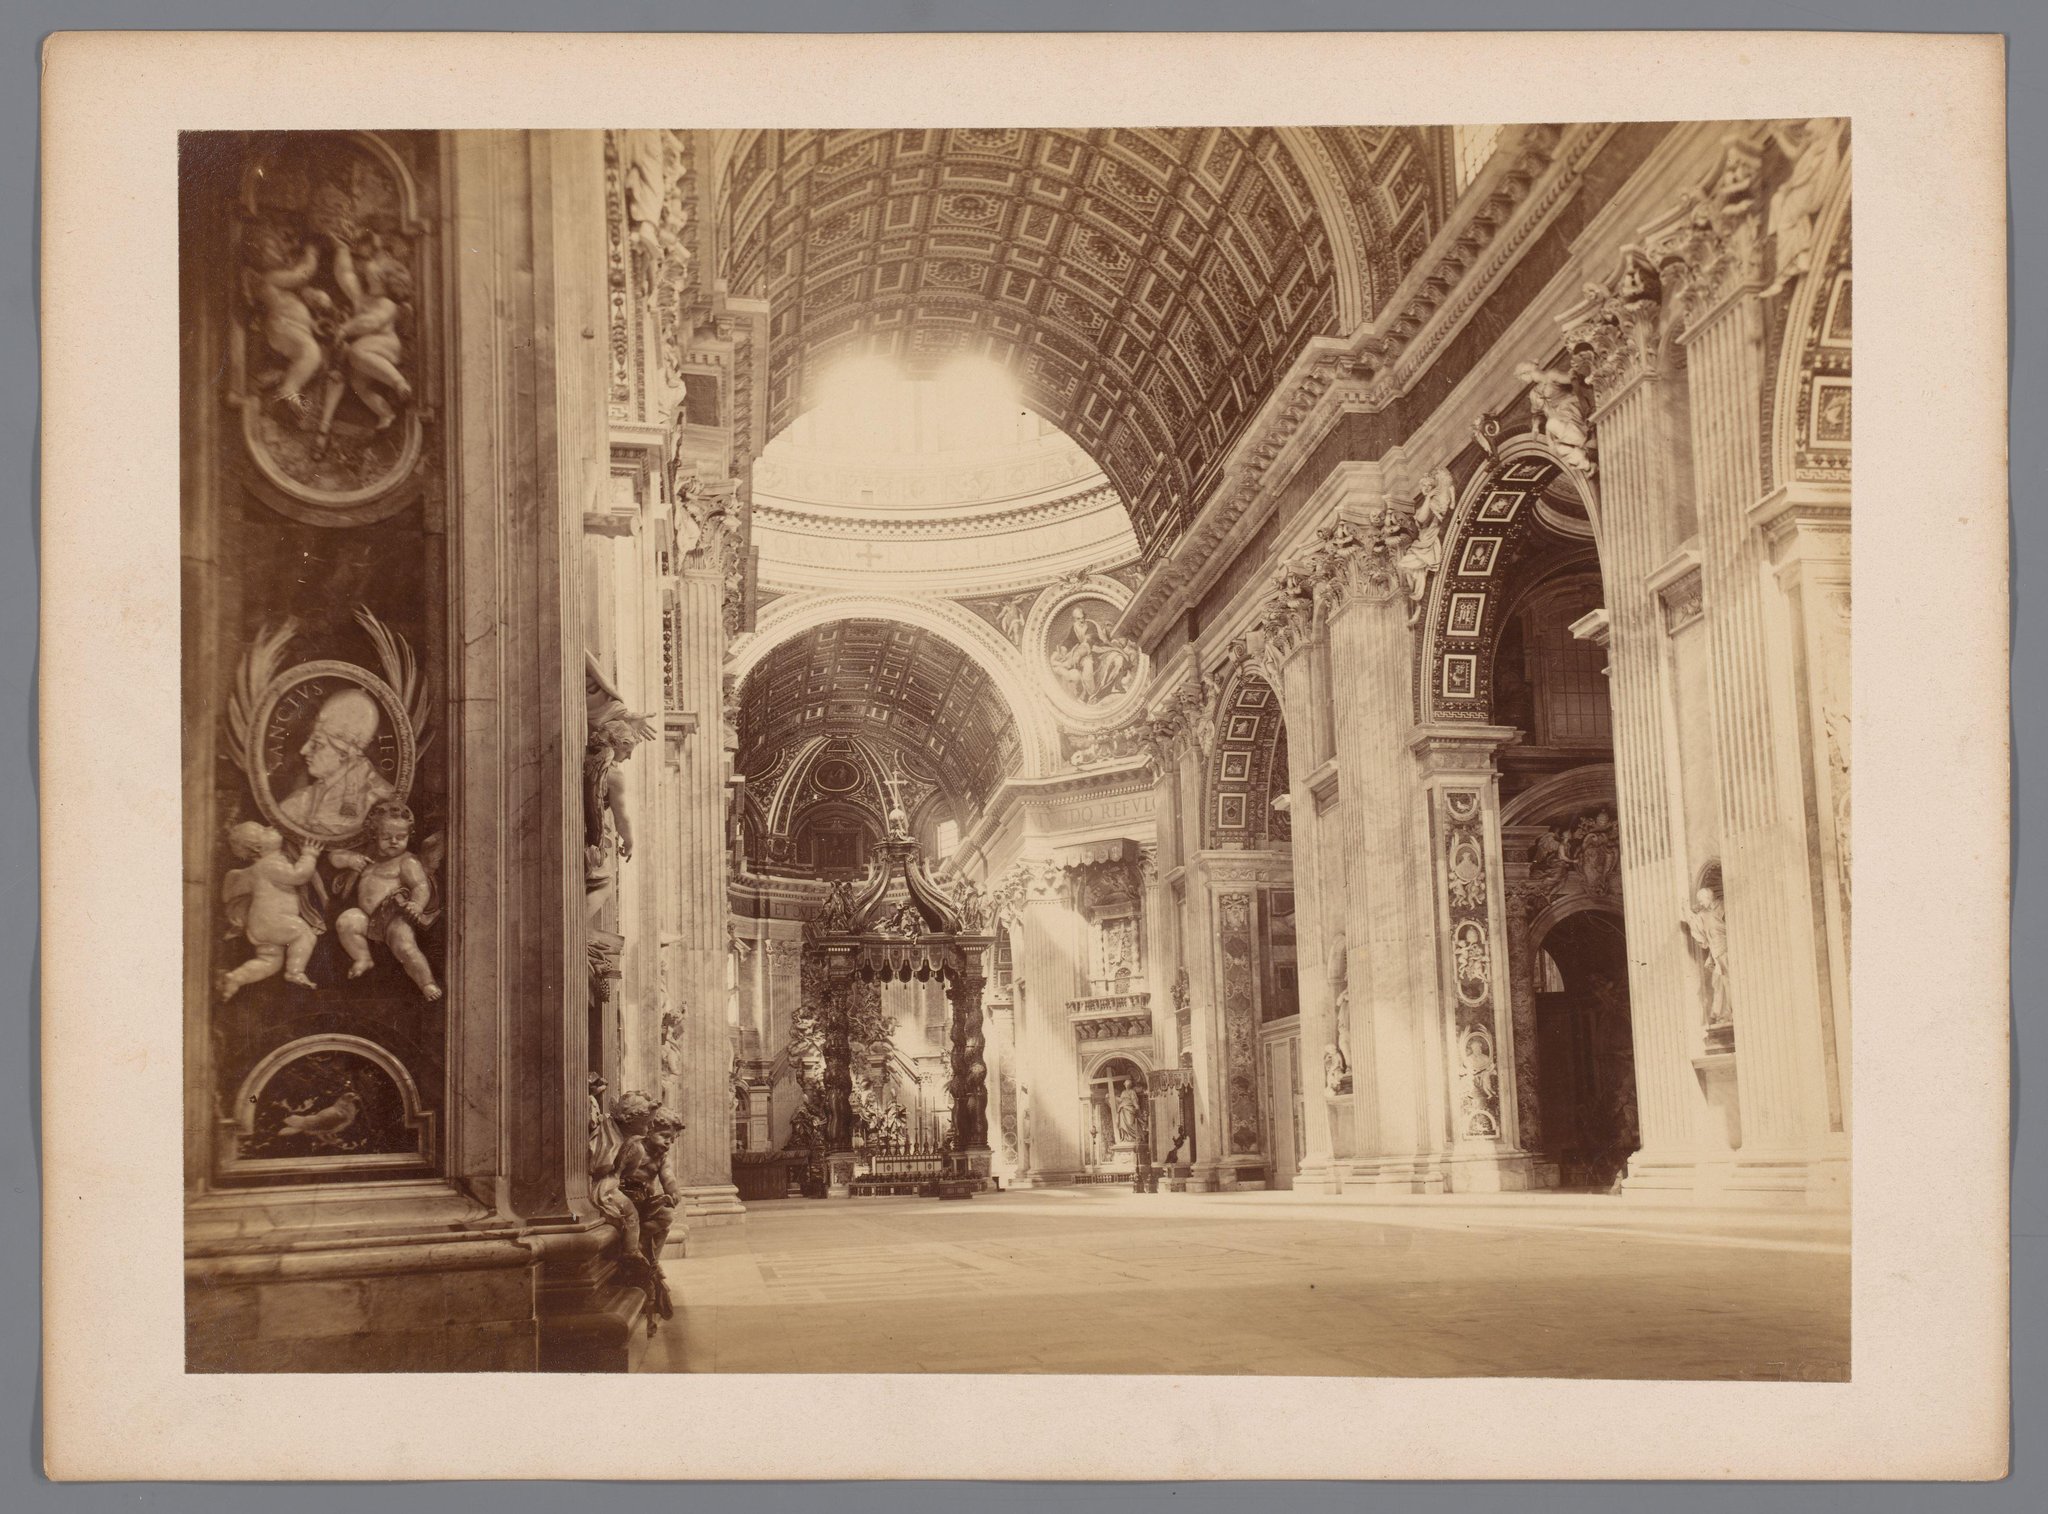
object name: photograph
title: Interieur van de Sint-Pietersbasiliek te Vaticaanstad, Italië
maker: Anonymous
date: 1851-1900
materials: cardboard, paper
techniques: albumen print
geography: vatican city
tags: parts of church interior